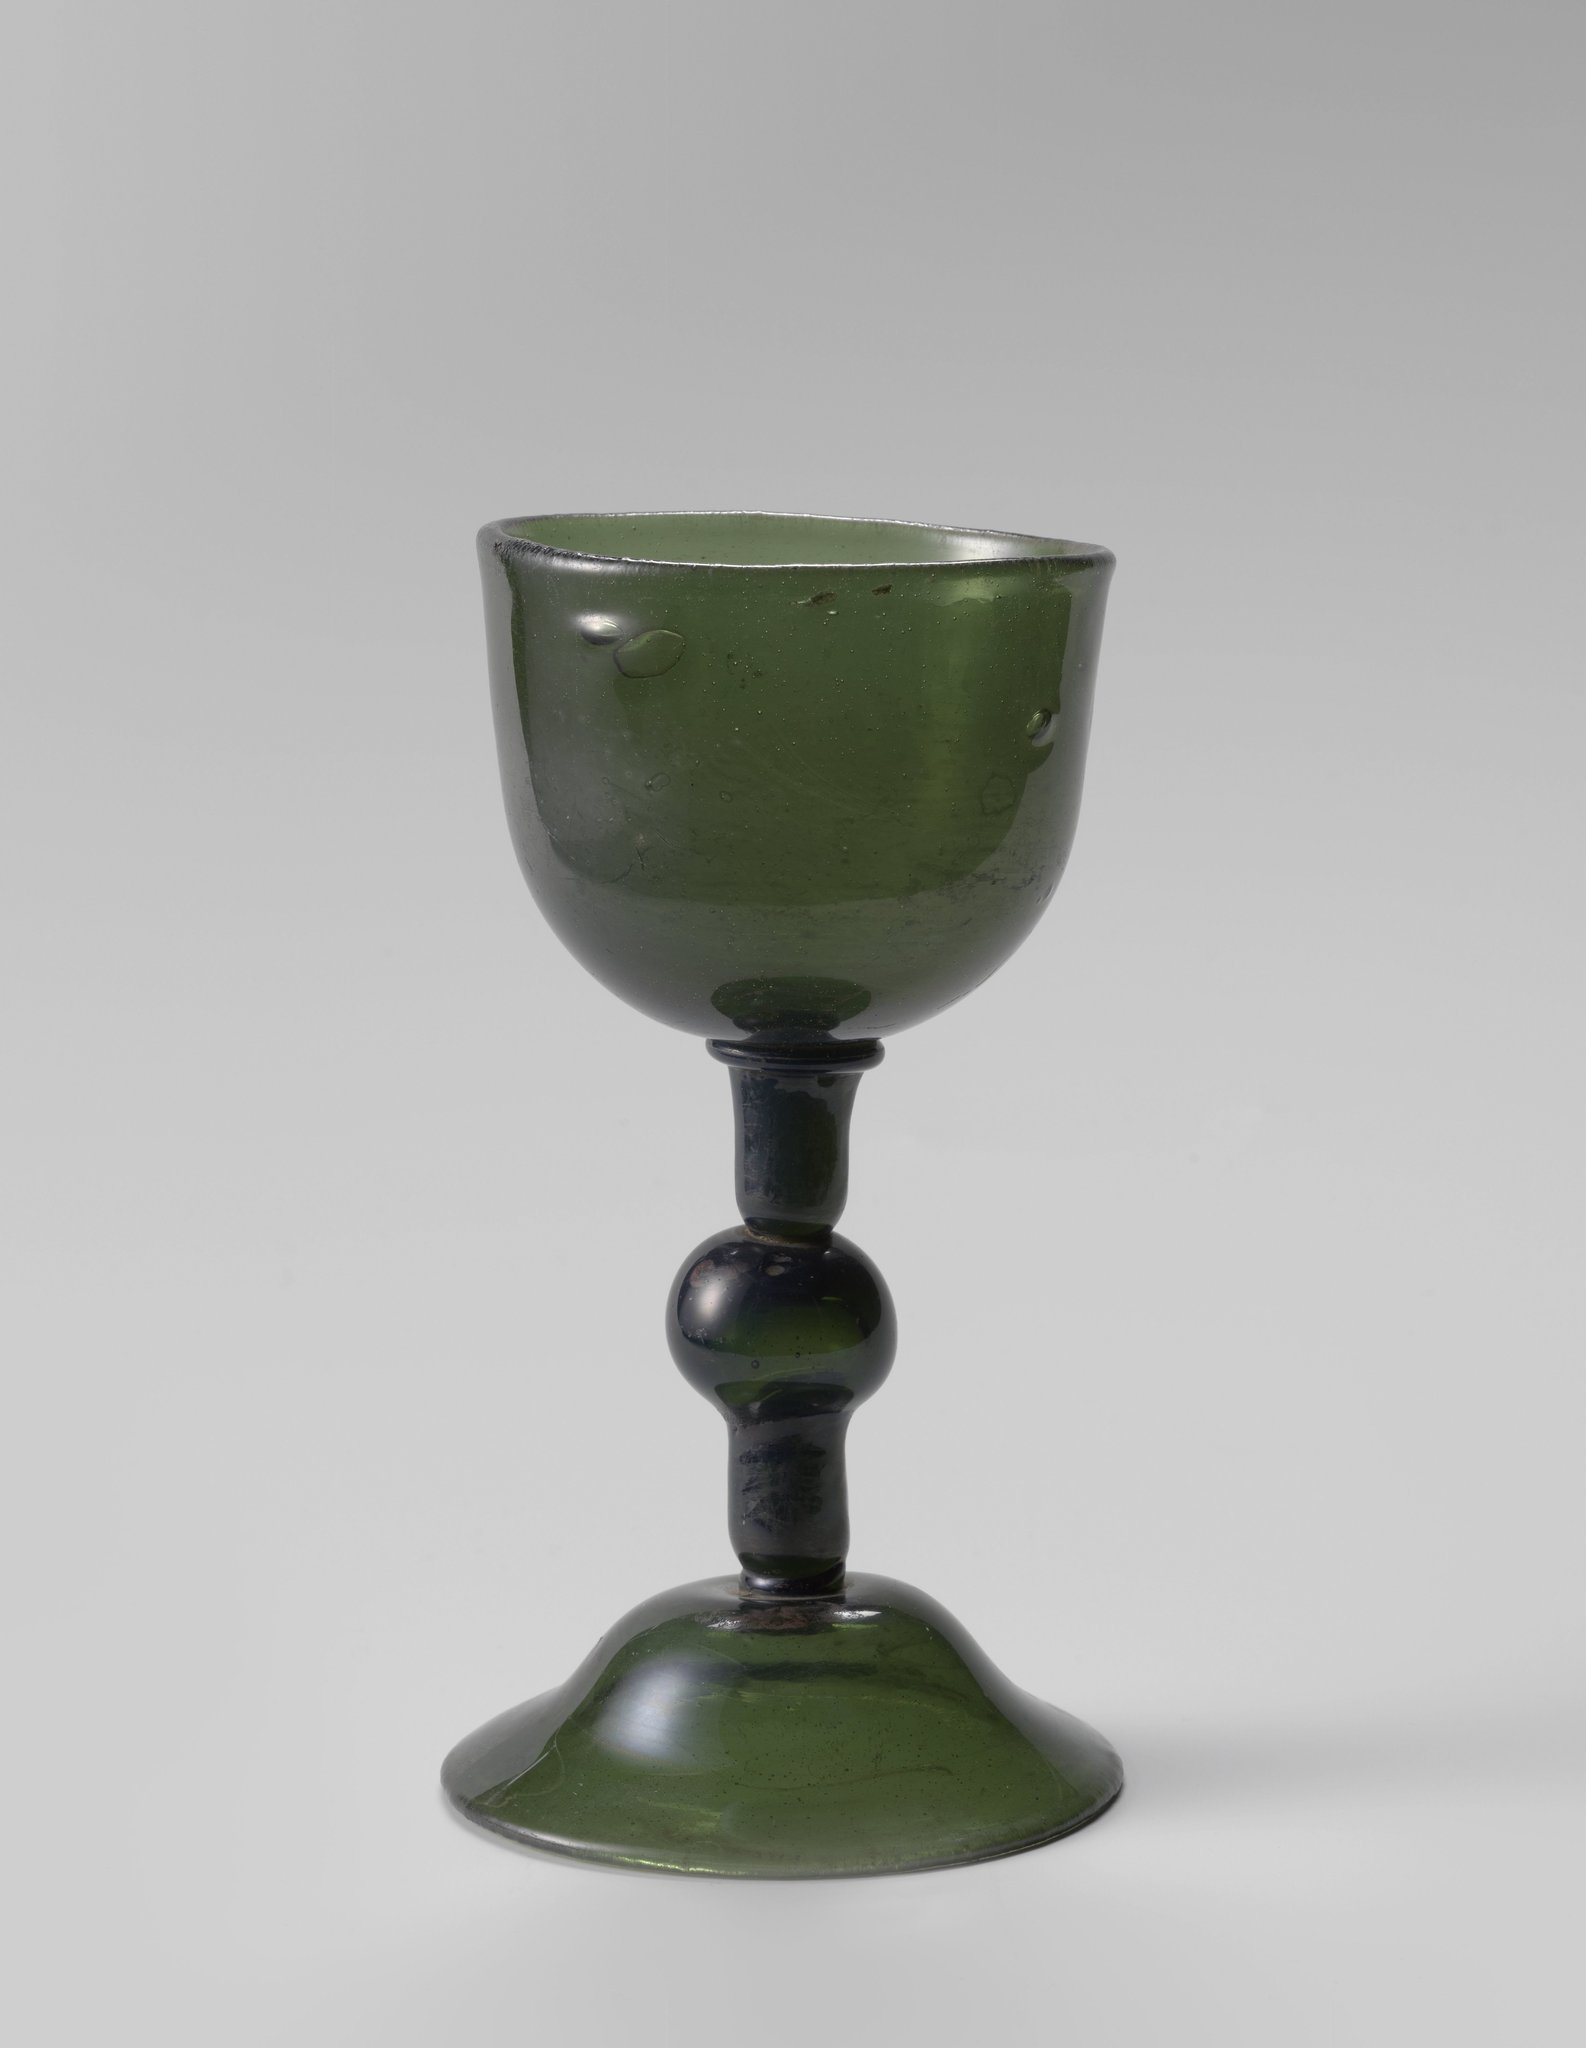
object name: goblet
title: Bokaal van groen glas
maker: Anonymous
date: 1875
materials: glass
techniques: glassblowing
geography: europe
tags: cranendonck castle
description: Bokaal van donkergroen glas, op gewelfde voet. Cilindervormige, massieve stam, met in het midden een massieve nodus. Komvormige kelk.